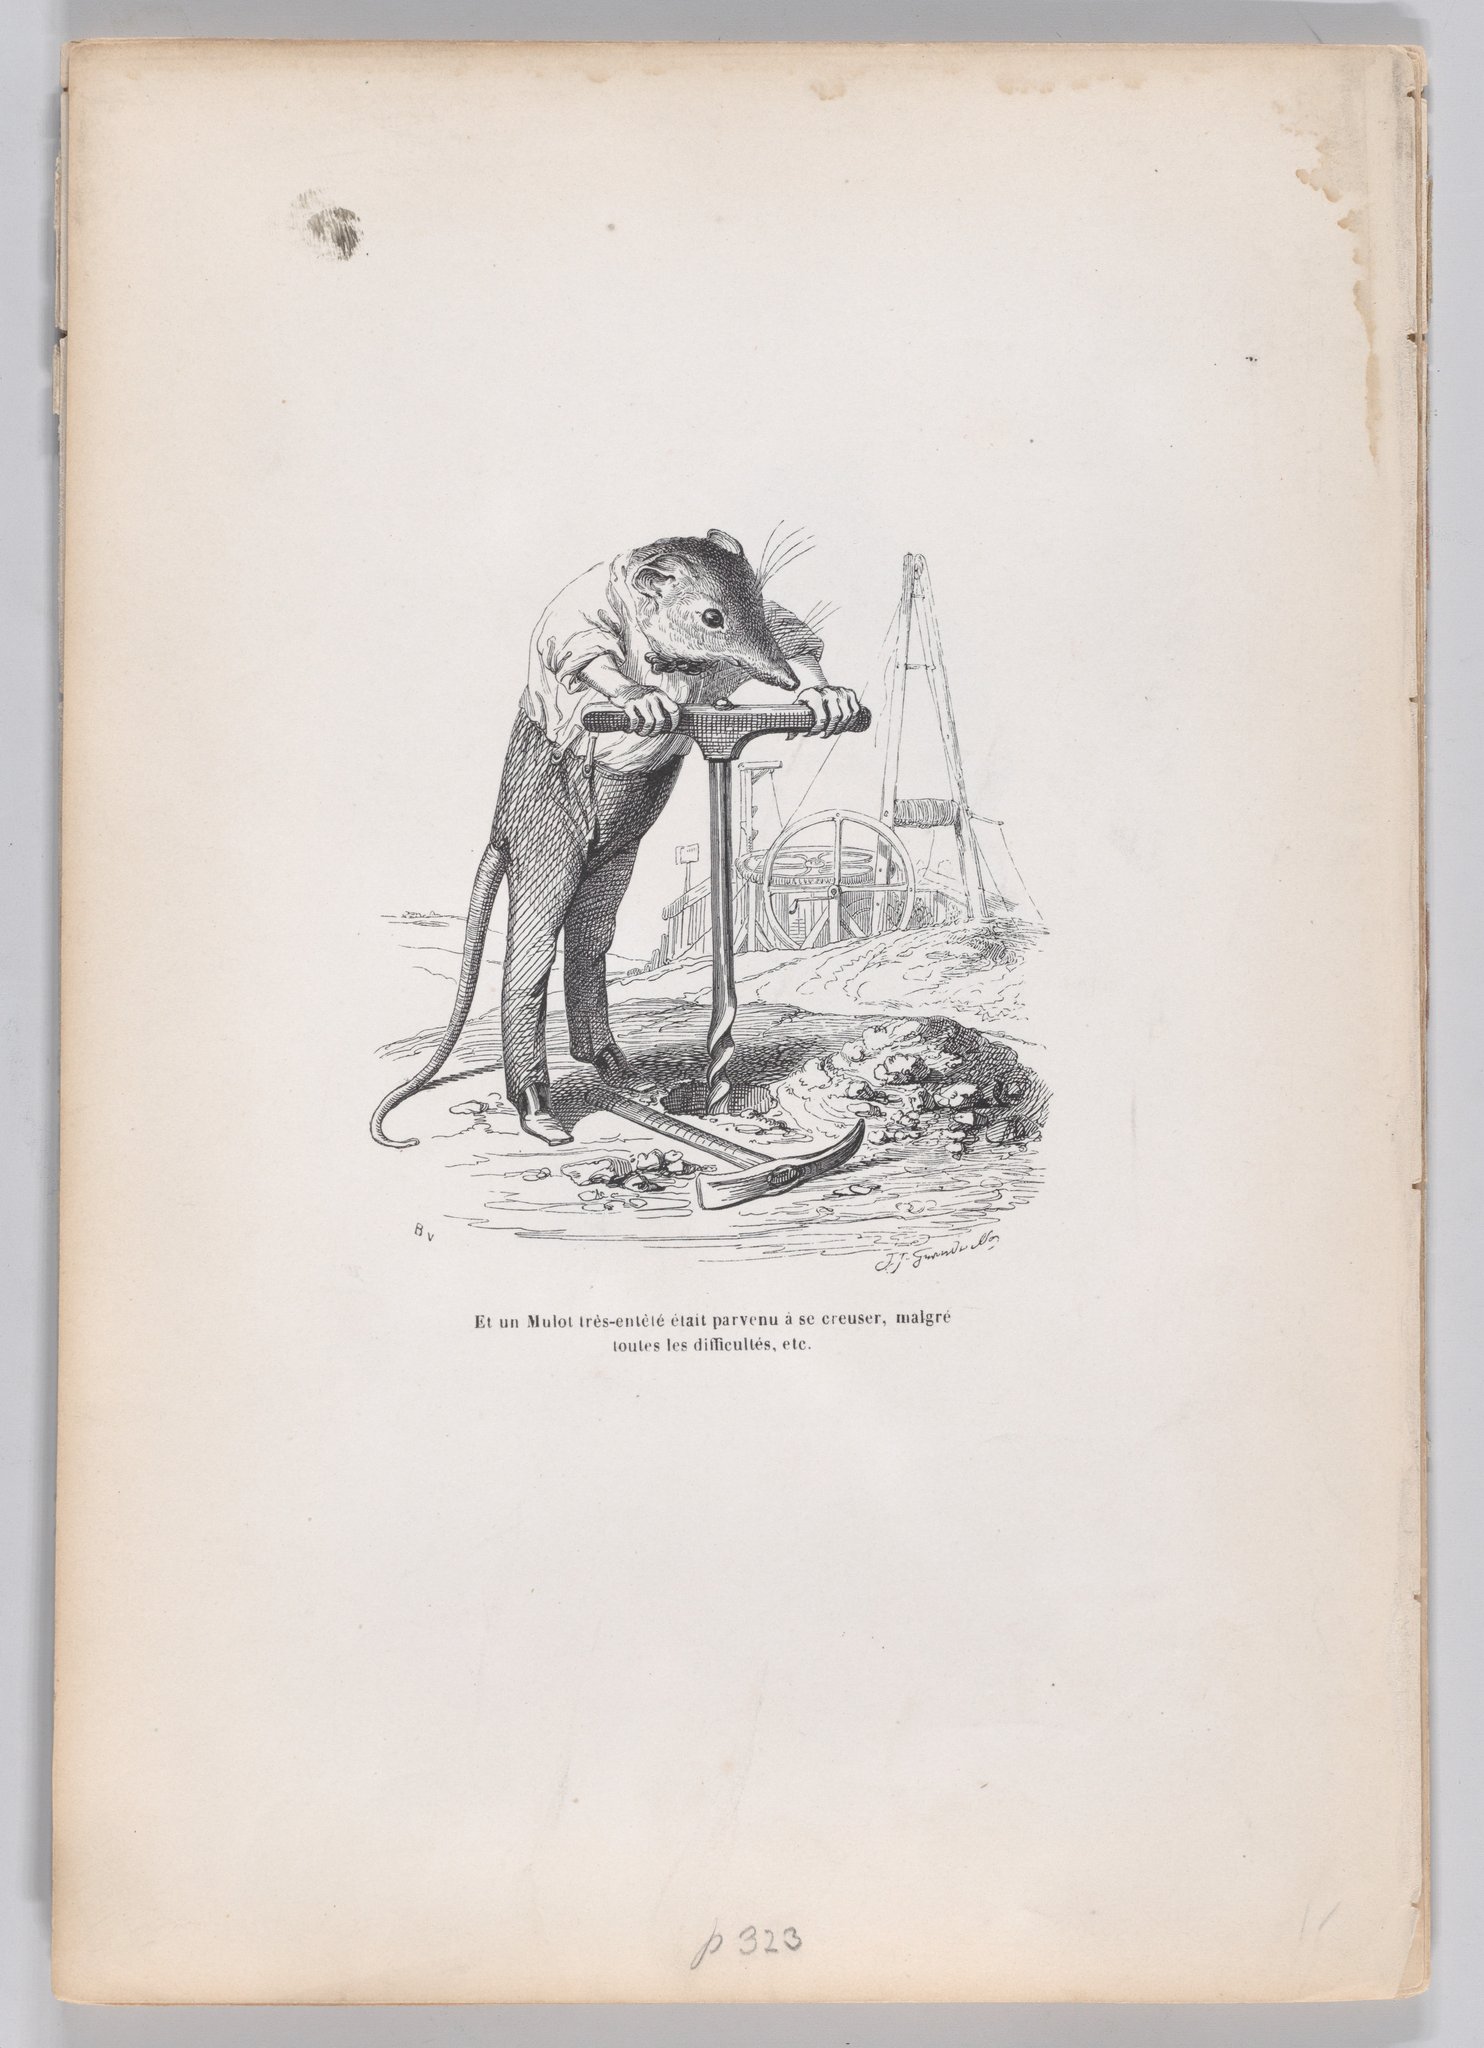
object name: print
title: And a very obstinate vole..., from "Scenes from the Private and Public Life of Animals"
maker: j. j. grandville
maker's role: illustrator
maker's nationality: french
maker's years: 1803-1847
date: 1837-1847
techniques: engraving